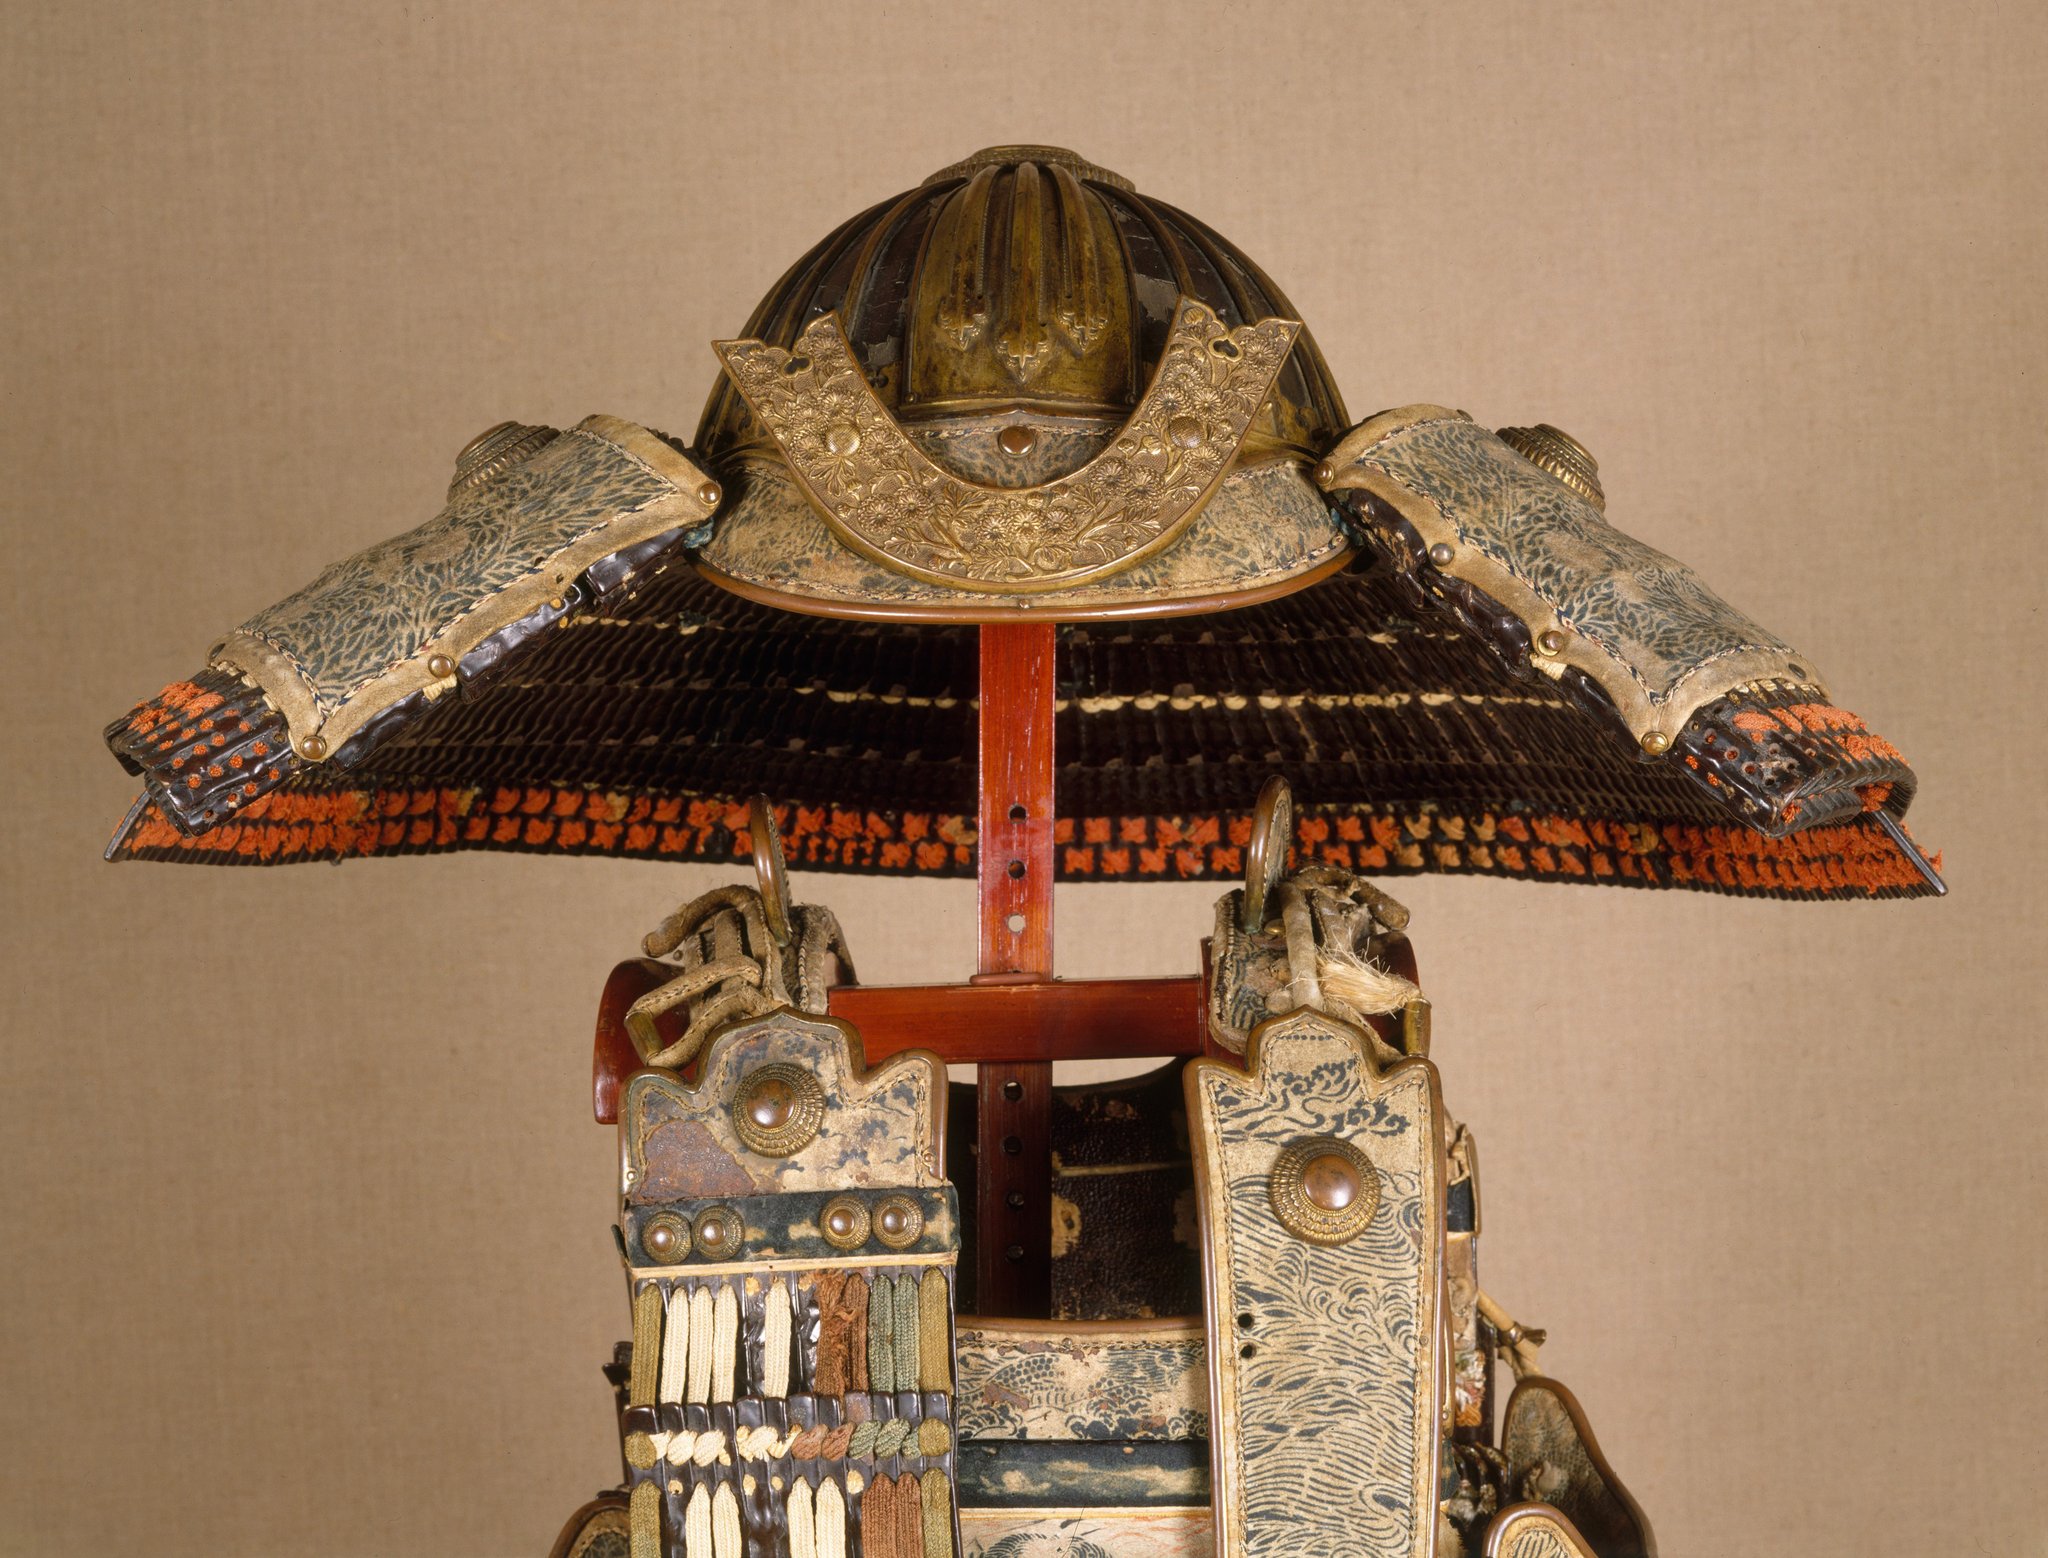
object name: helmet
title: Helmet of Ashikaga Takauji (1305–1358)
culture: japanese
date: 1334-1366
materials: copper gilt, iron, lacquer, leather, silk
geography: japan